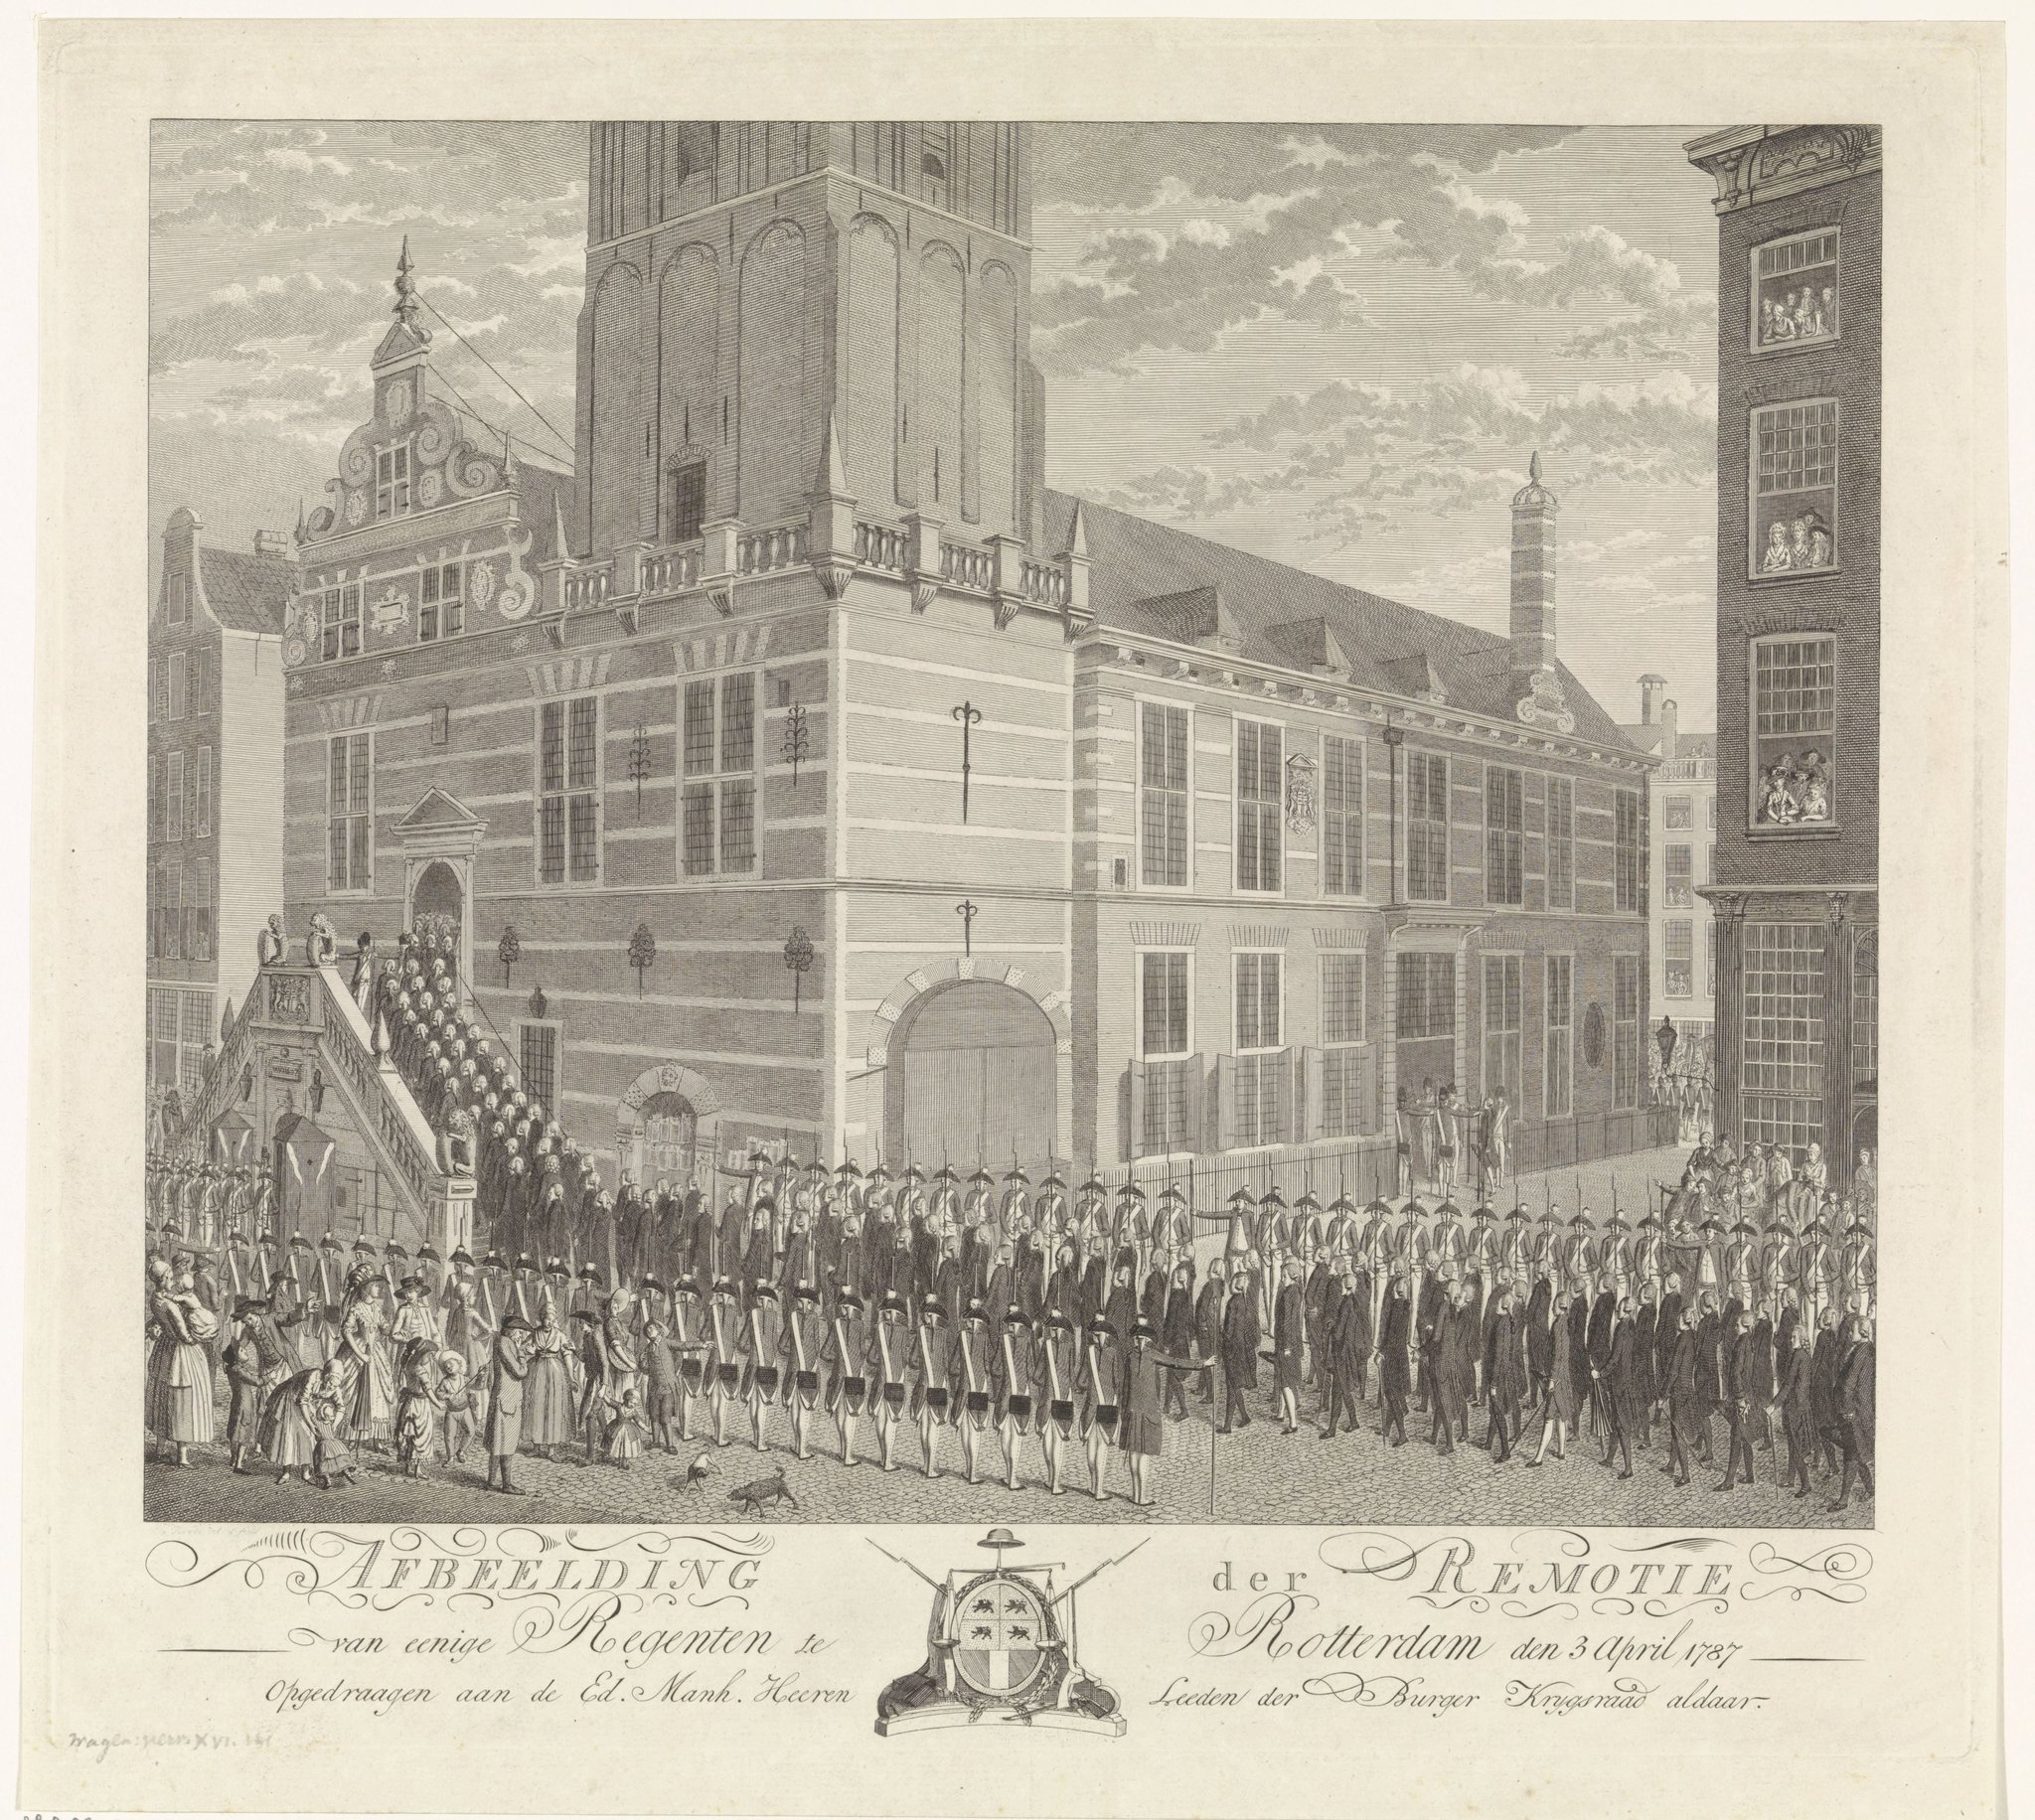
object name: print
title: Afbeelding der Remotie van eenige Regenten te Rotterdam 3 April 1787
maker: theodorus de roode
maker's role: draughtsman, print maker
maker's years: 1736-1793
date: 1787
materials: paper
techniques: engraving, etching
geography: rotterdam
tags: rotterdam, patriots (1780-1795)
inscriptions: collector's mark: Lugt 2228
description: Gezicht op het oude stadhuis van Rotterdam, waar op 3 april 1787 zeven regenten werden afgezet. Vanaf de straat en vanuit de omliggende huizen kijken mensen toe. De prent is opgedragen aan 'Ed. Manh. Heeren Leeden der Burger Krygsraad' van Rotterdam.